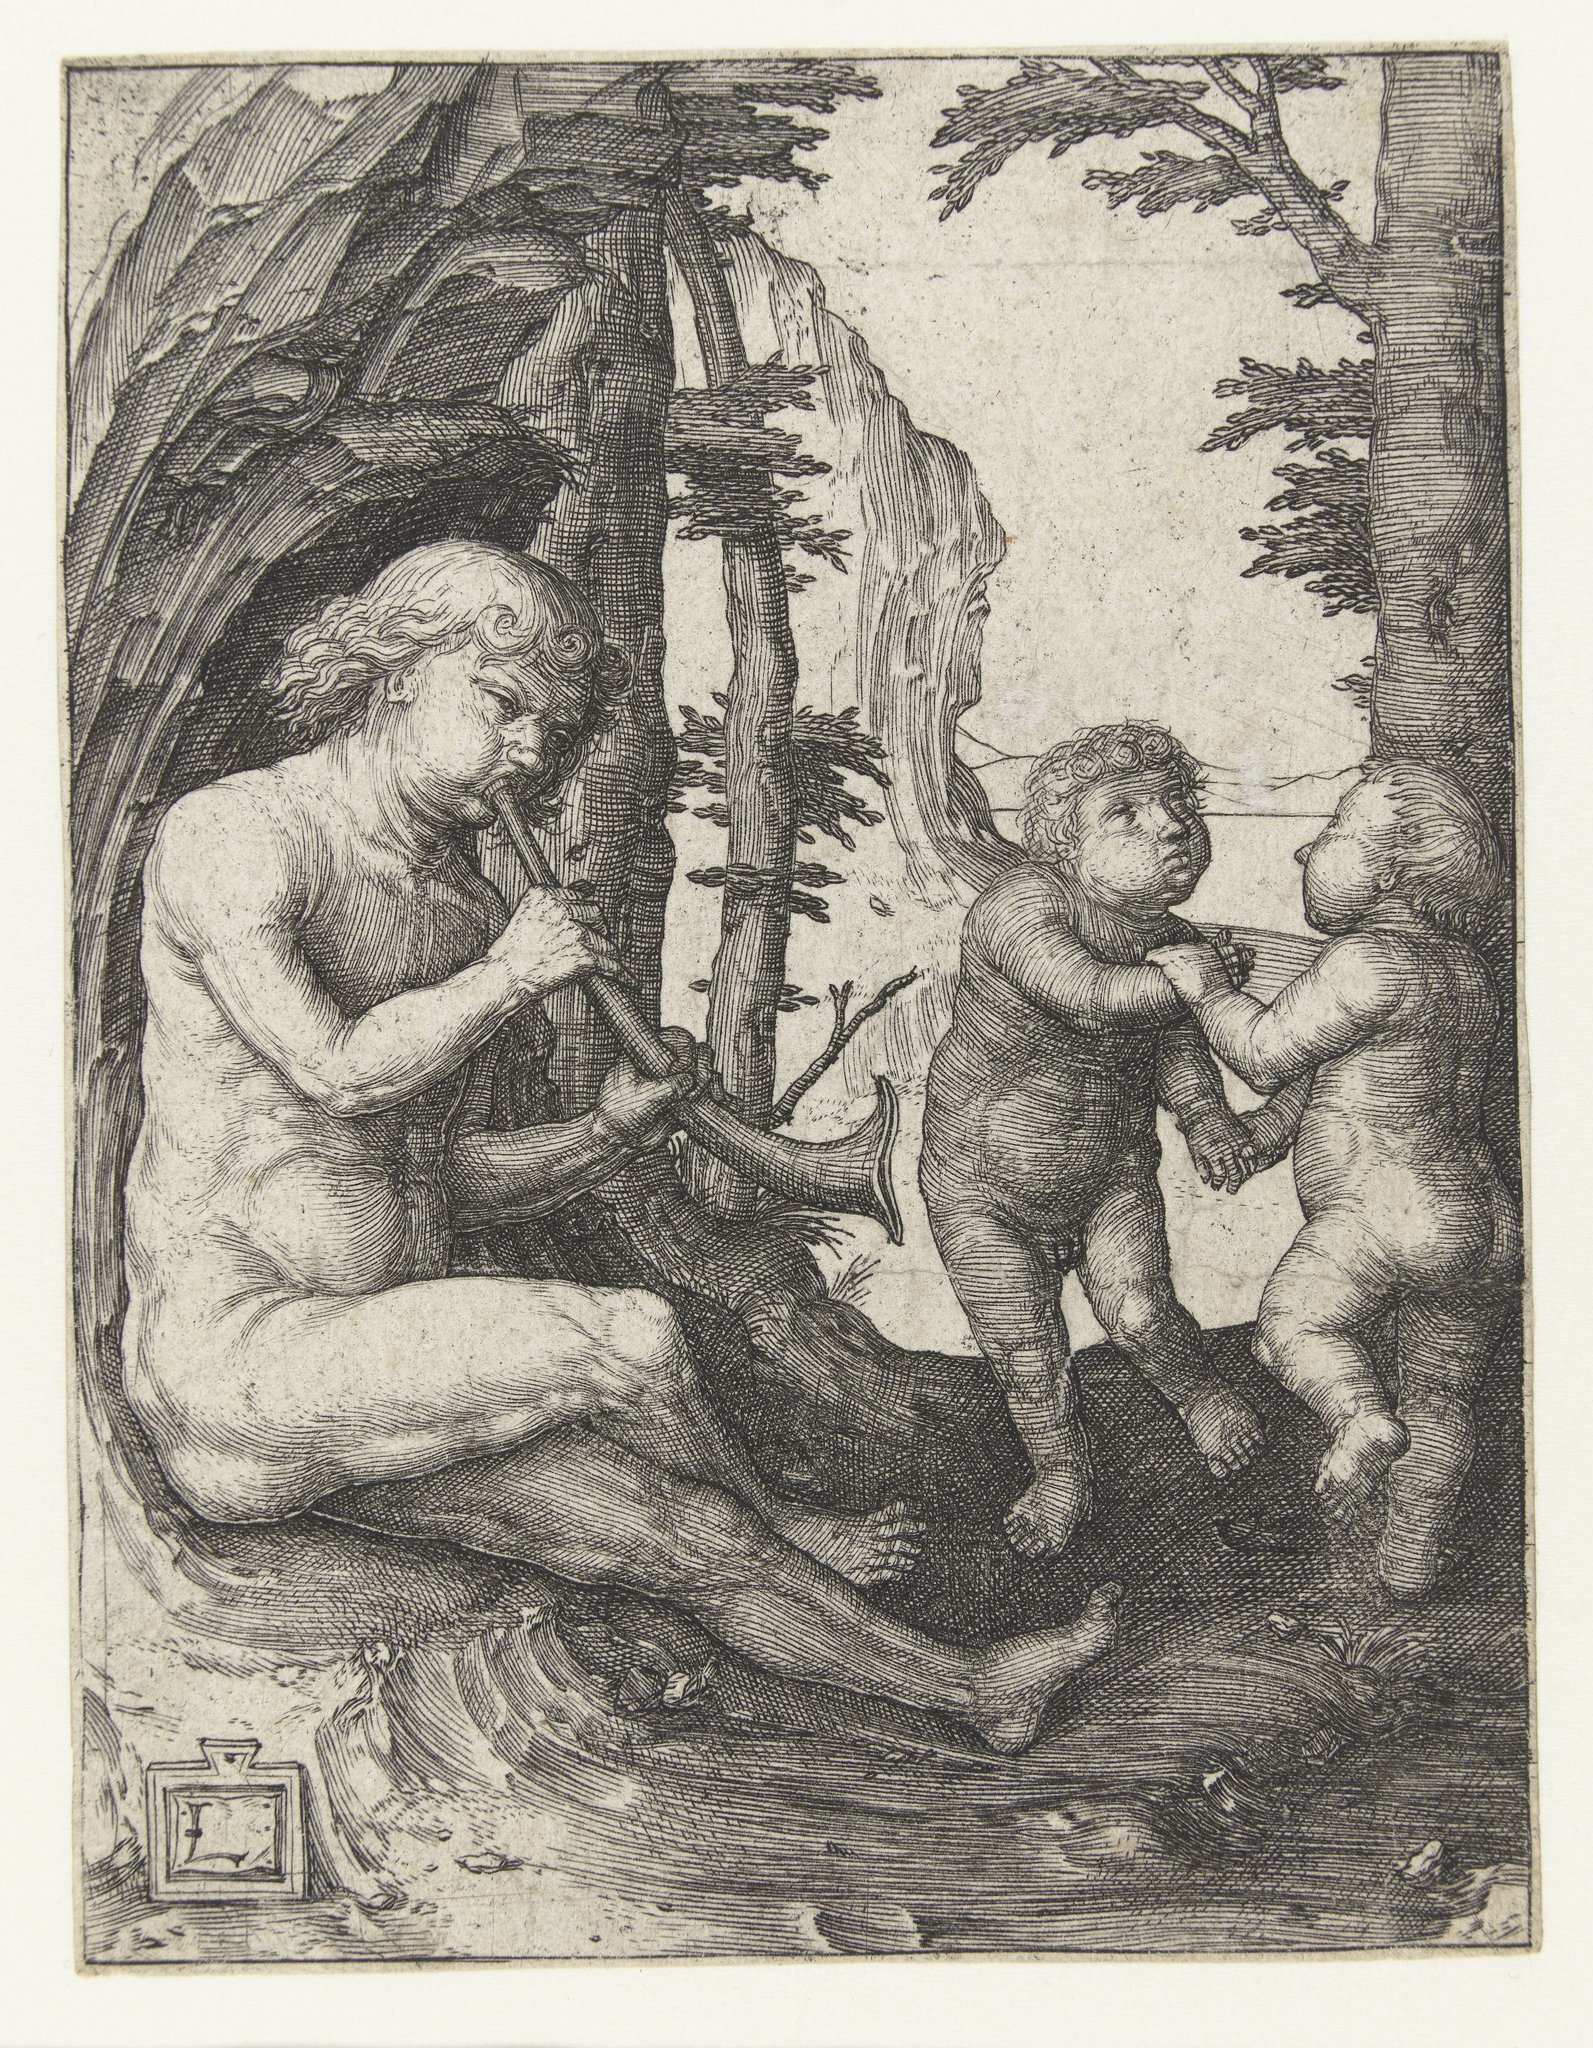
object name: print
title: Jongen met blaasinstrument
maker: lucas van leyden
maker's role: draughtsman, painter, print maker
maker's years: 1494-1533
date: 1505-1509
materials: paper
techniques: engraving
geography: low countries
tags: dancing, horn, trumpet, cornet, trombone, tuba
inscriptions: collector's mark: Lugt 240, signature: ‘L’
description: Zittende naakte jongen blazend op soort hoorn, twee naakte jongetjes dansend.